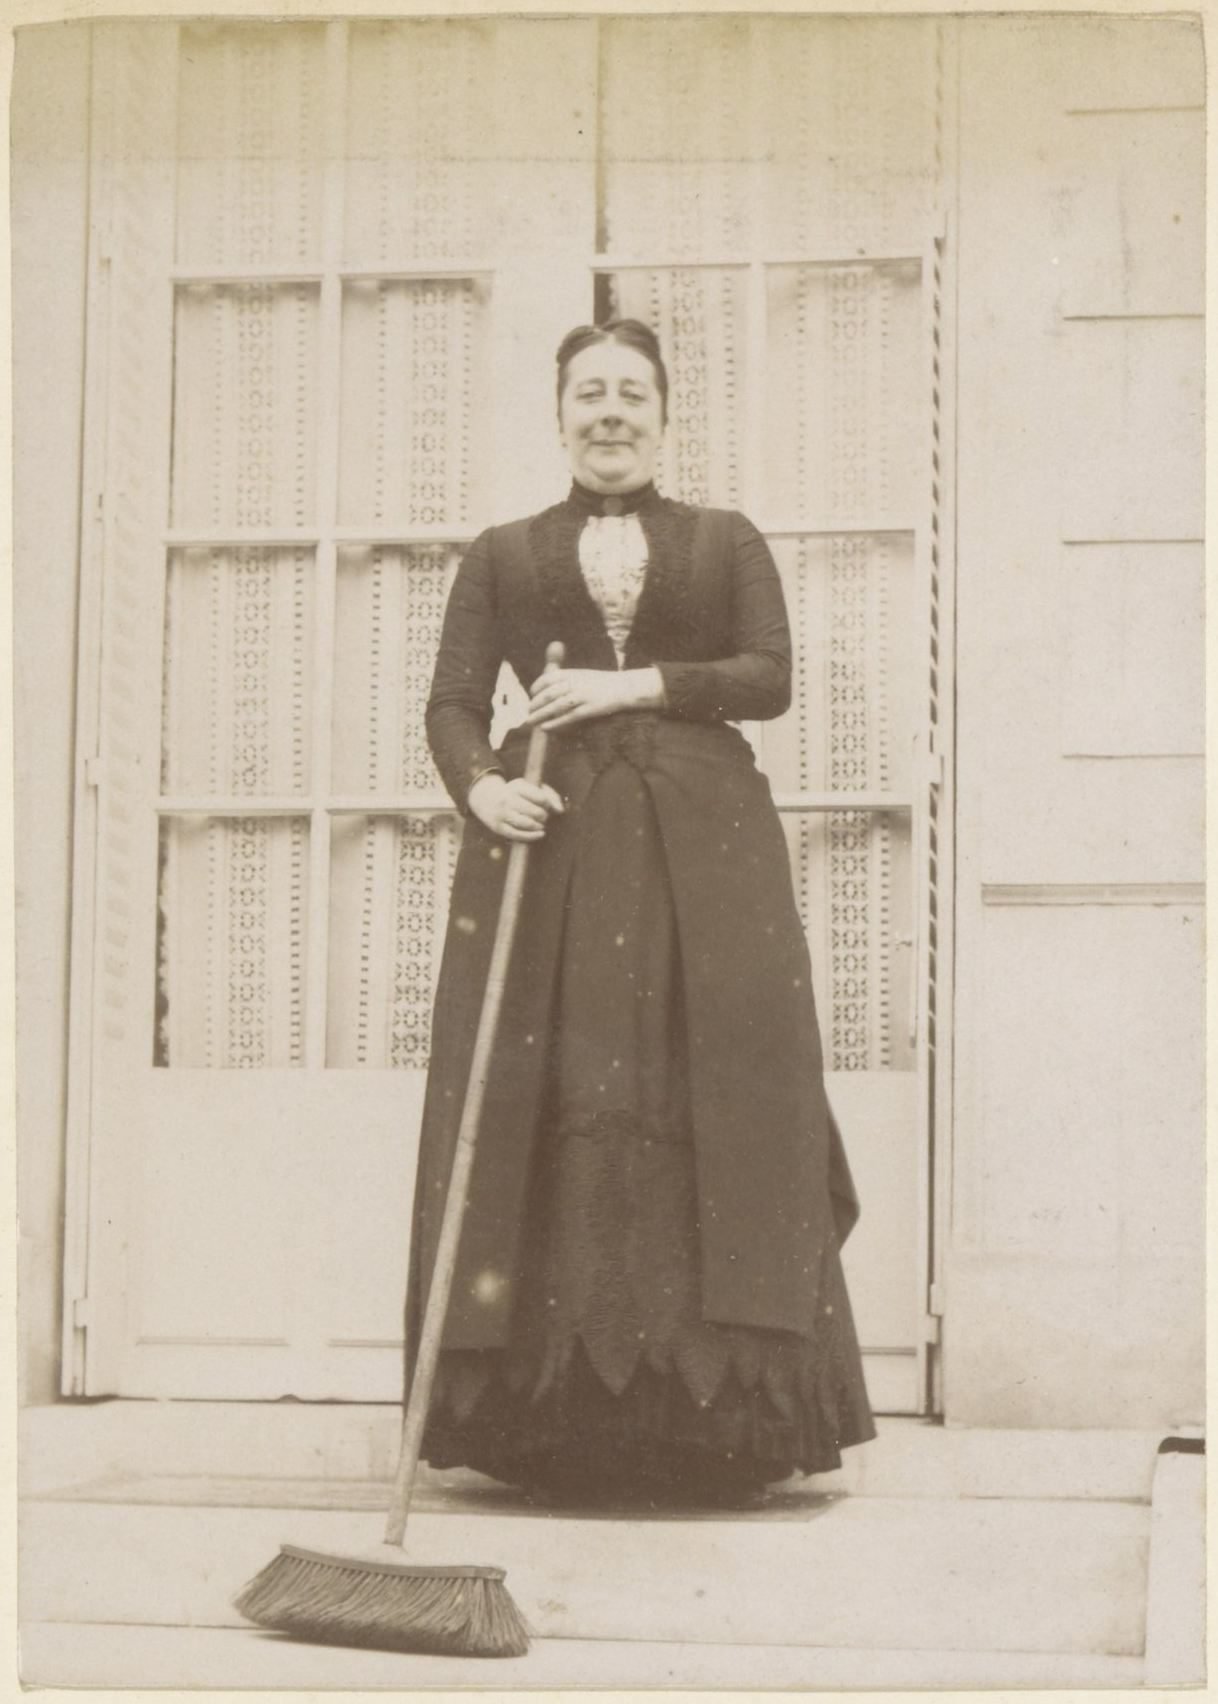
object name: photograph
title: Portret van een Franse vrouw, staand met bezem in de hand op de stoep van een huis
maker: Anonymous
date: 1900-1910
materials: paper, photographic support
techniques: albumen print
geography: france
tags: adult woman, dress, gown, shrubs: broom, france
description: Onderdeel van Fotoalbum van een Franse amateurfotograaf met opnames van een familie, distilleerderij Delizy & Doistau Fils, het leger en bezienswaardigheden in Frankrijk.